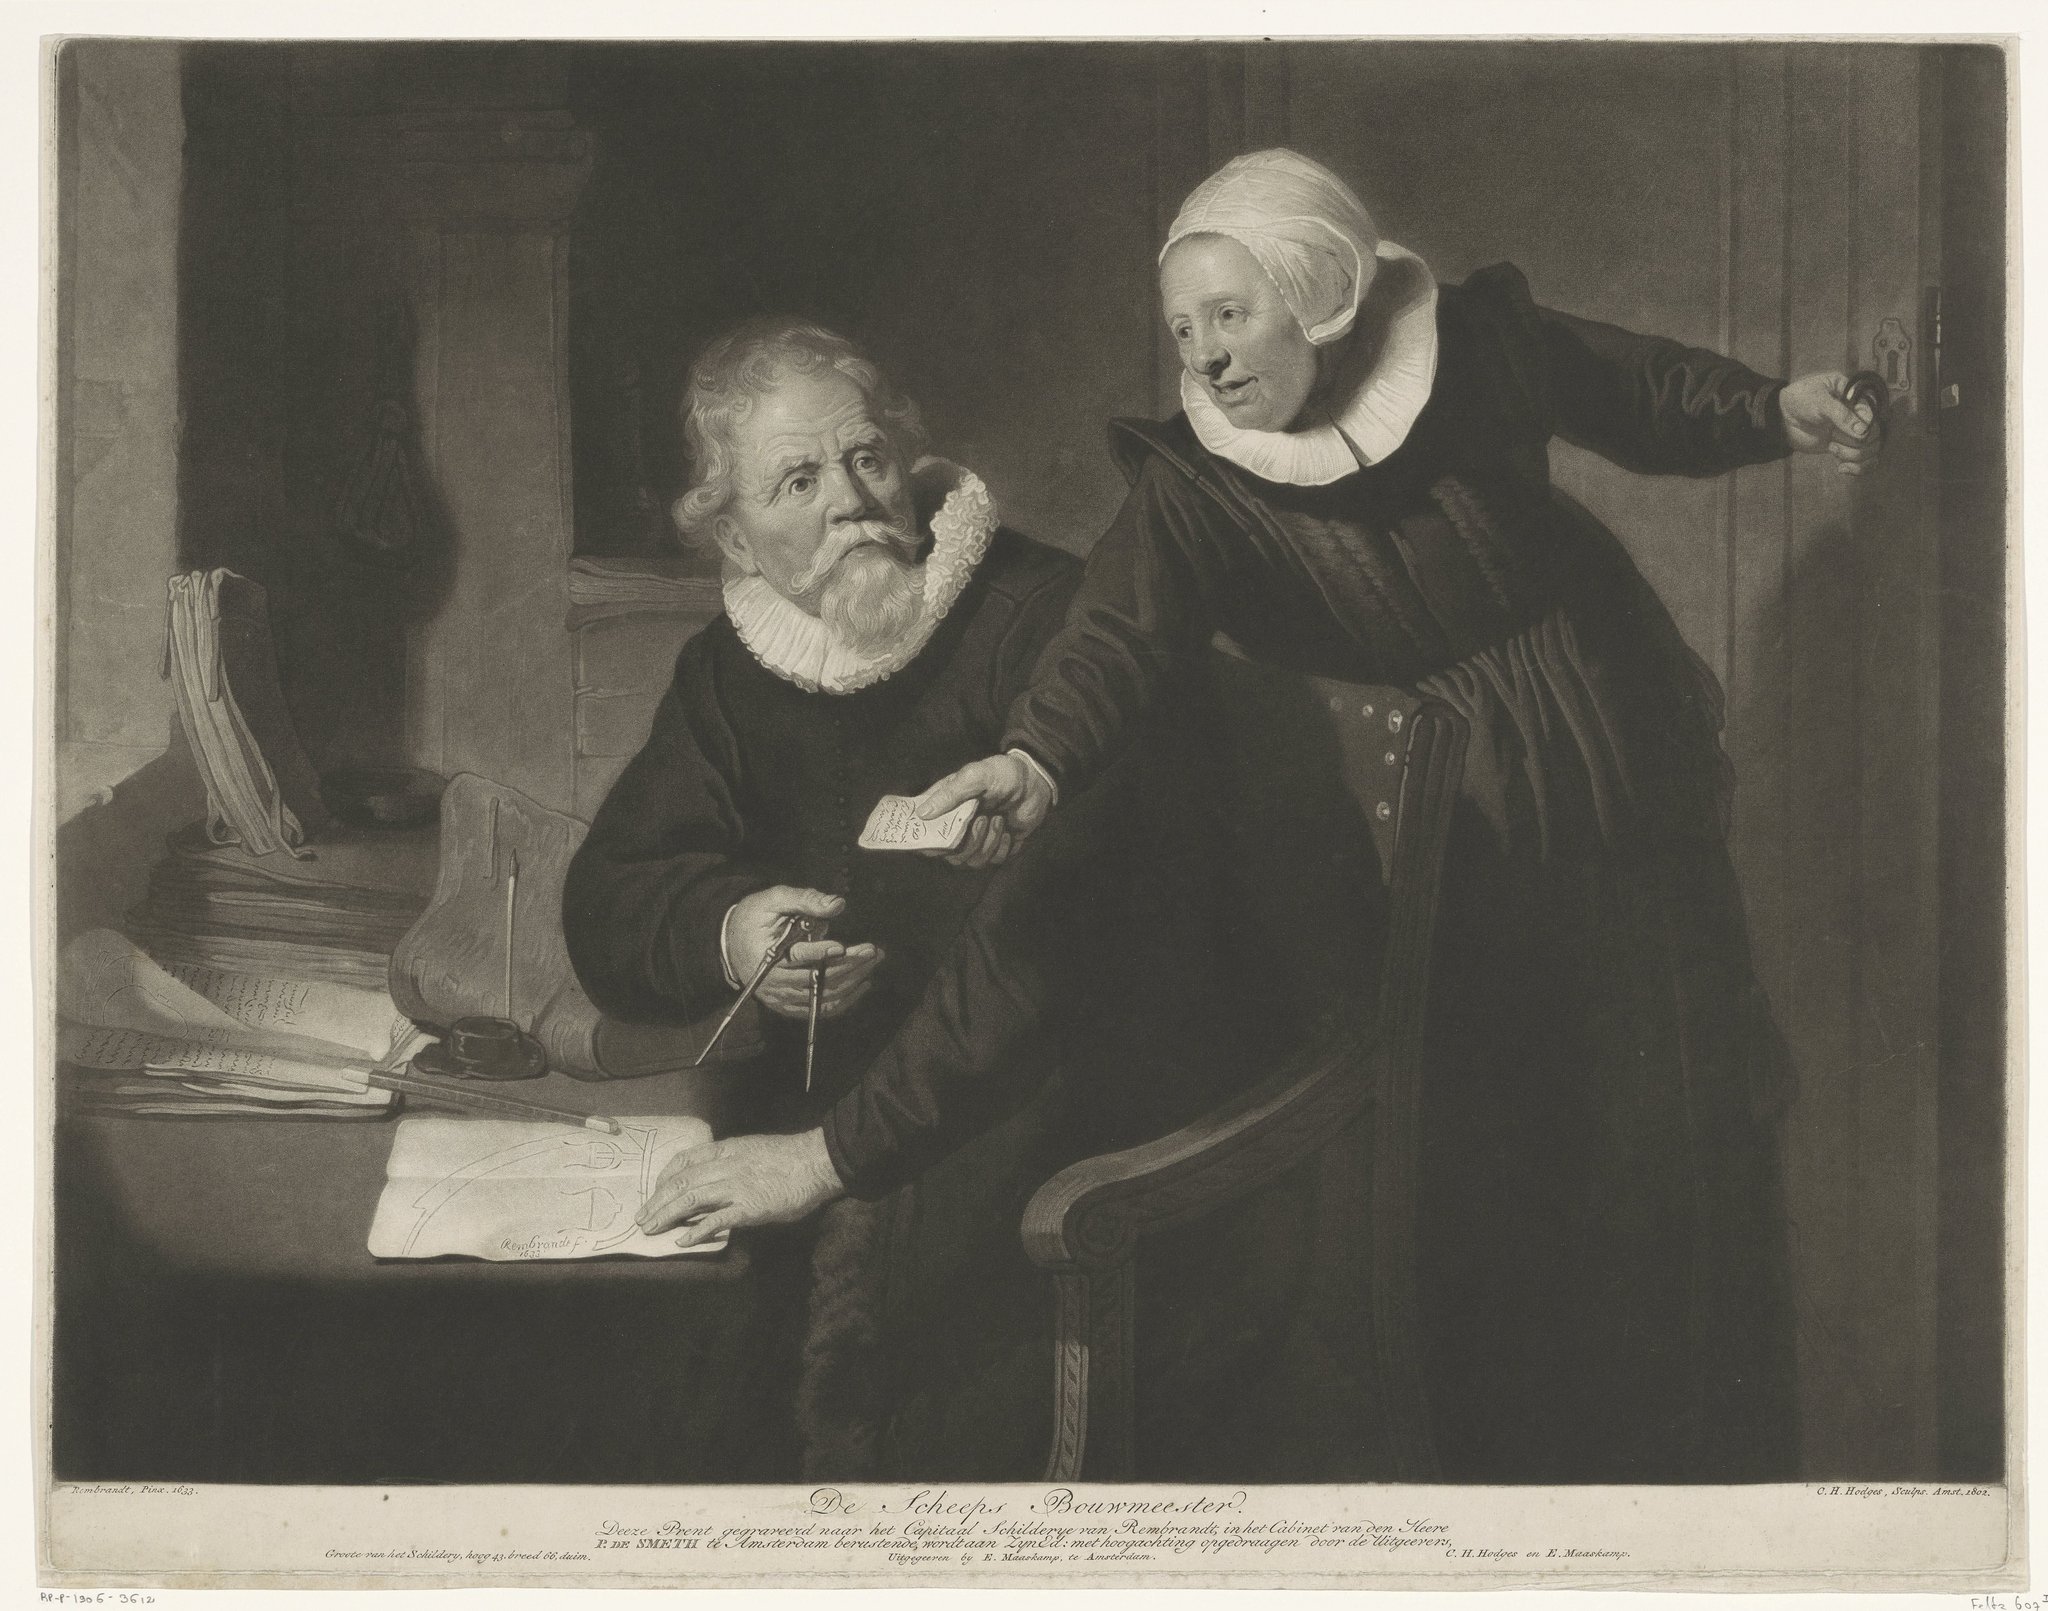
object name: print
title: De Scheeps Bouwmeester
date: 1802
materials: paper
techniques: etching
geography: amsterdam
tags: marriage, married couple, 'matrimonium', shipbuilding industry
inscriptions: collector's mark: Lugt 2228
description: Griet Jans komt de kamer binnen om haar man Jan Rijcksen een brief te geven. Met de passer nog in de hand neemt hij de brief aan. Op tafel voor hem ligt het ontwerp van een scheepskiel.